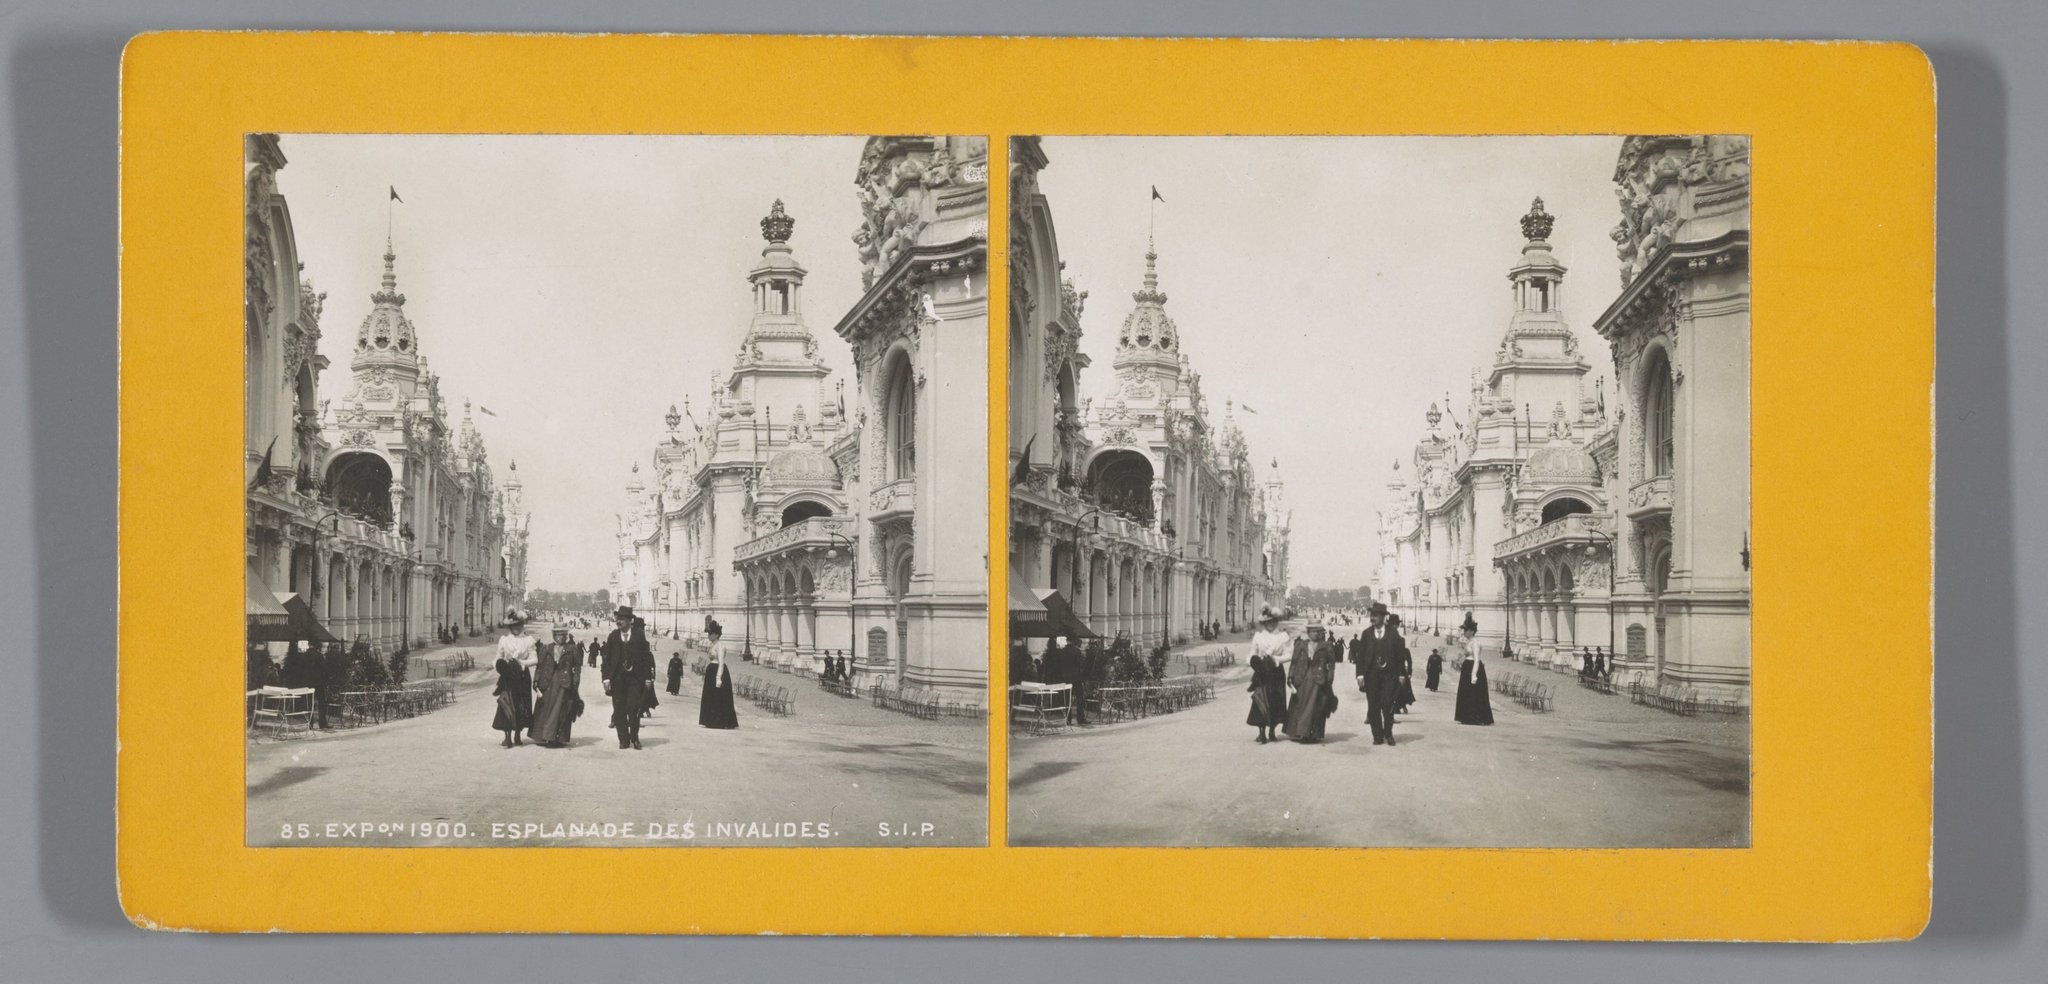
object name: stereograph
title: Expon 1900. Esplanade des Invalides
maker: Anonymous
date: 1900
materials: paper, cardboard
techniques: gelatin silver print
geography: paris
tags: world fair, world exhibition, avenue, boulevard, promenade, esplanade, paris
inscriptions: number: ‘85.’